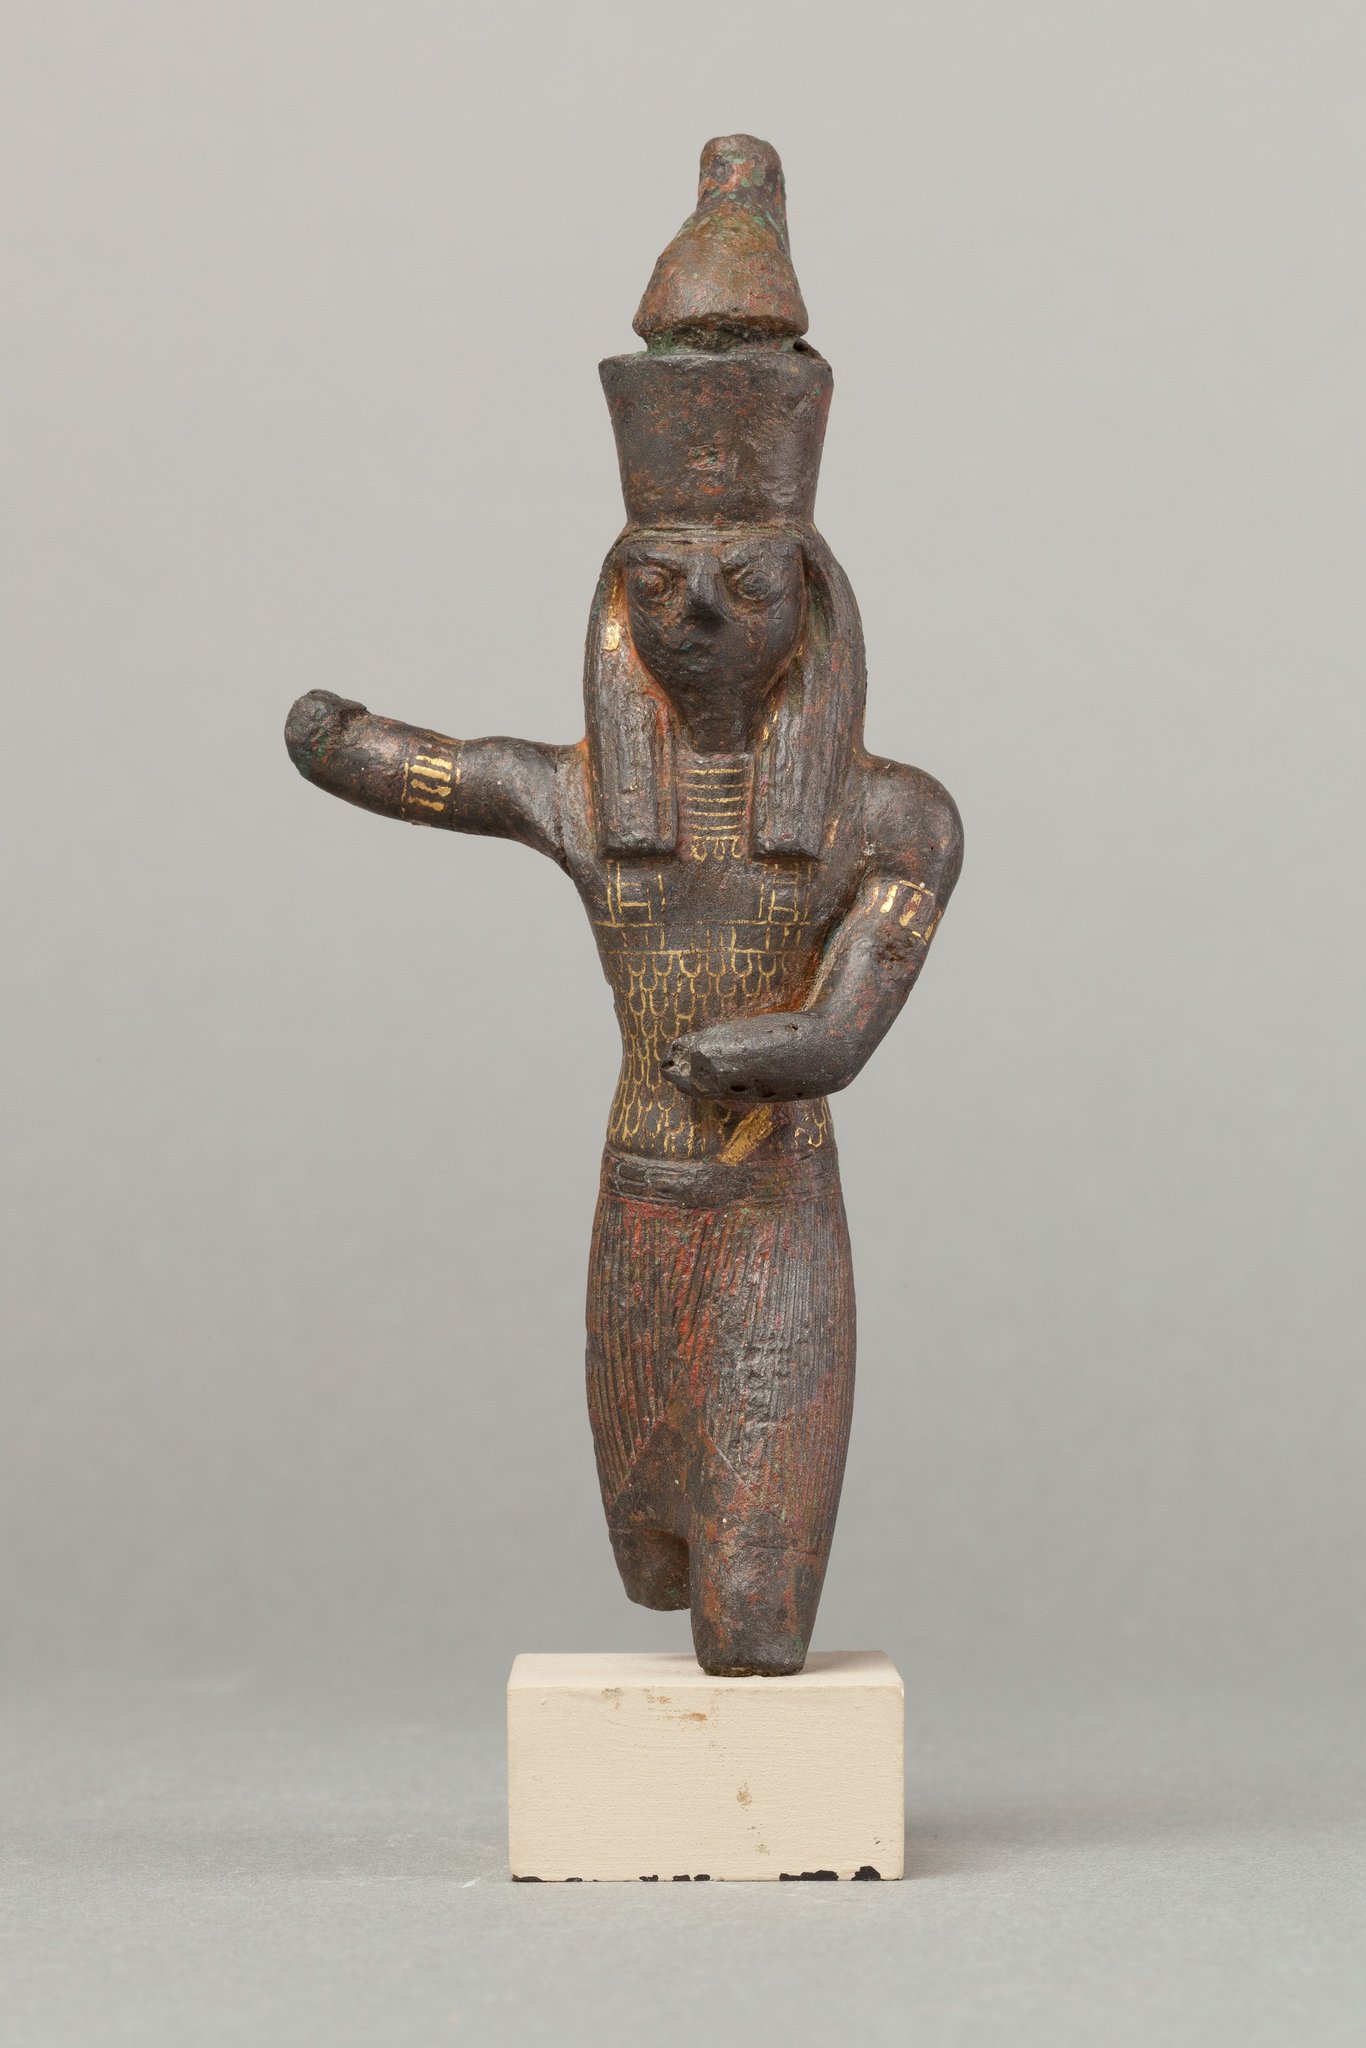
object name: statuette, horus, slaying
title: Horus slaying an antelope, spear and antelope (?) missing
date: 945-332 BCE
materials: metal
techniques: inlay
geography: egypt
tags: horus